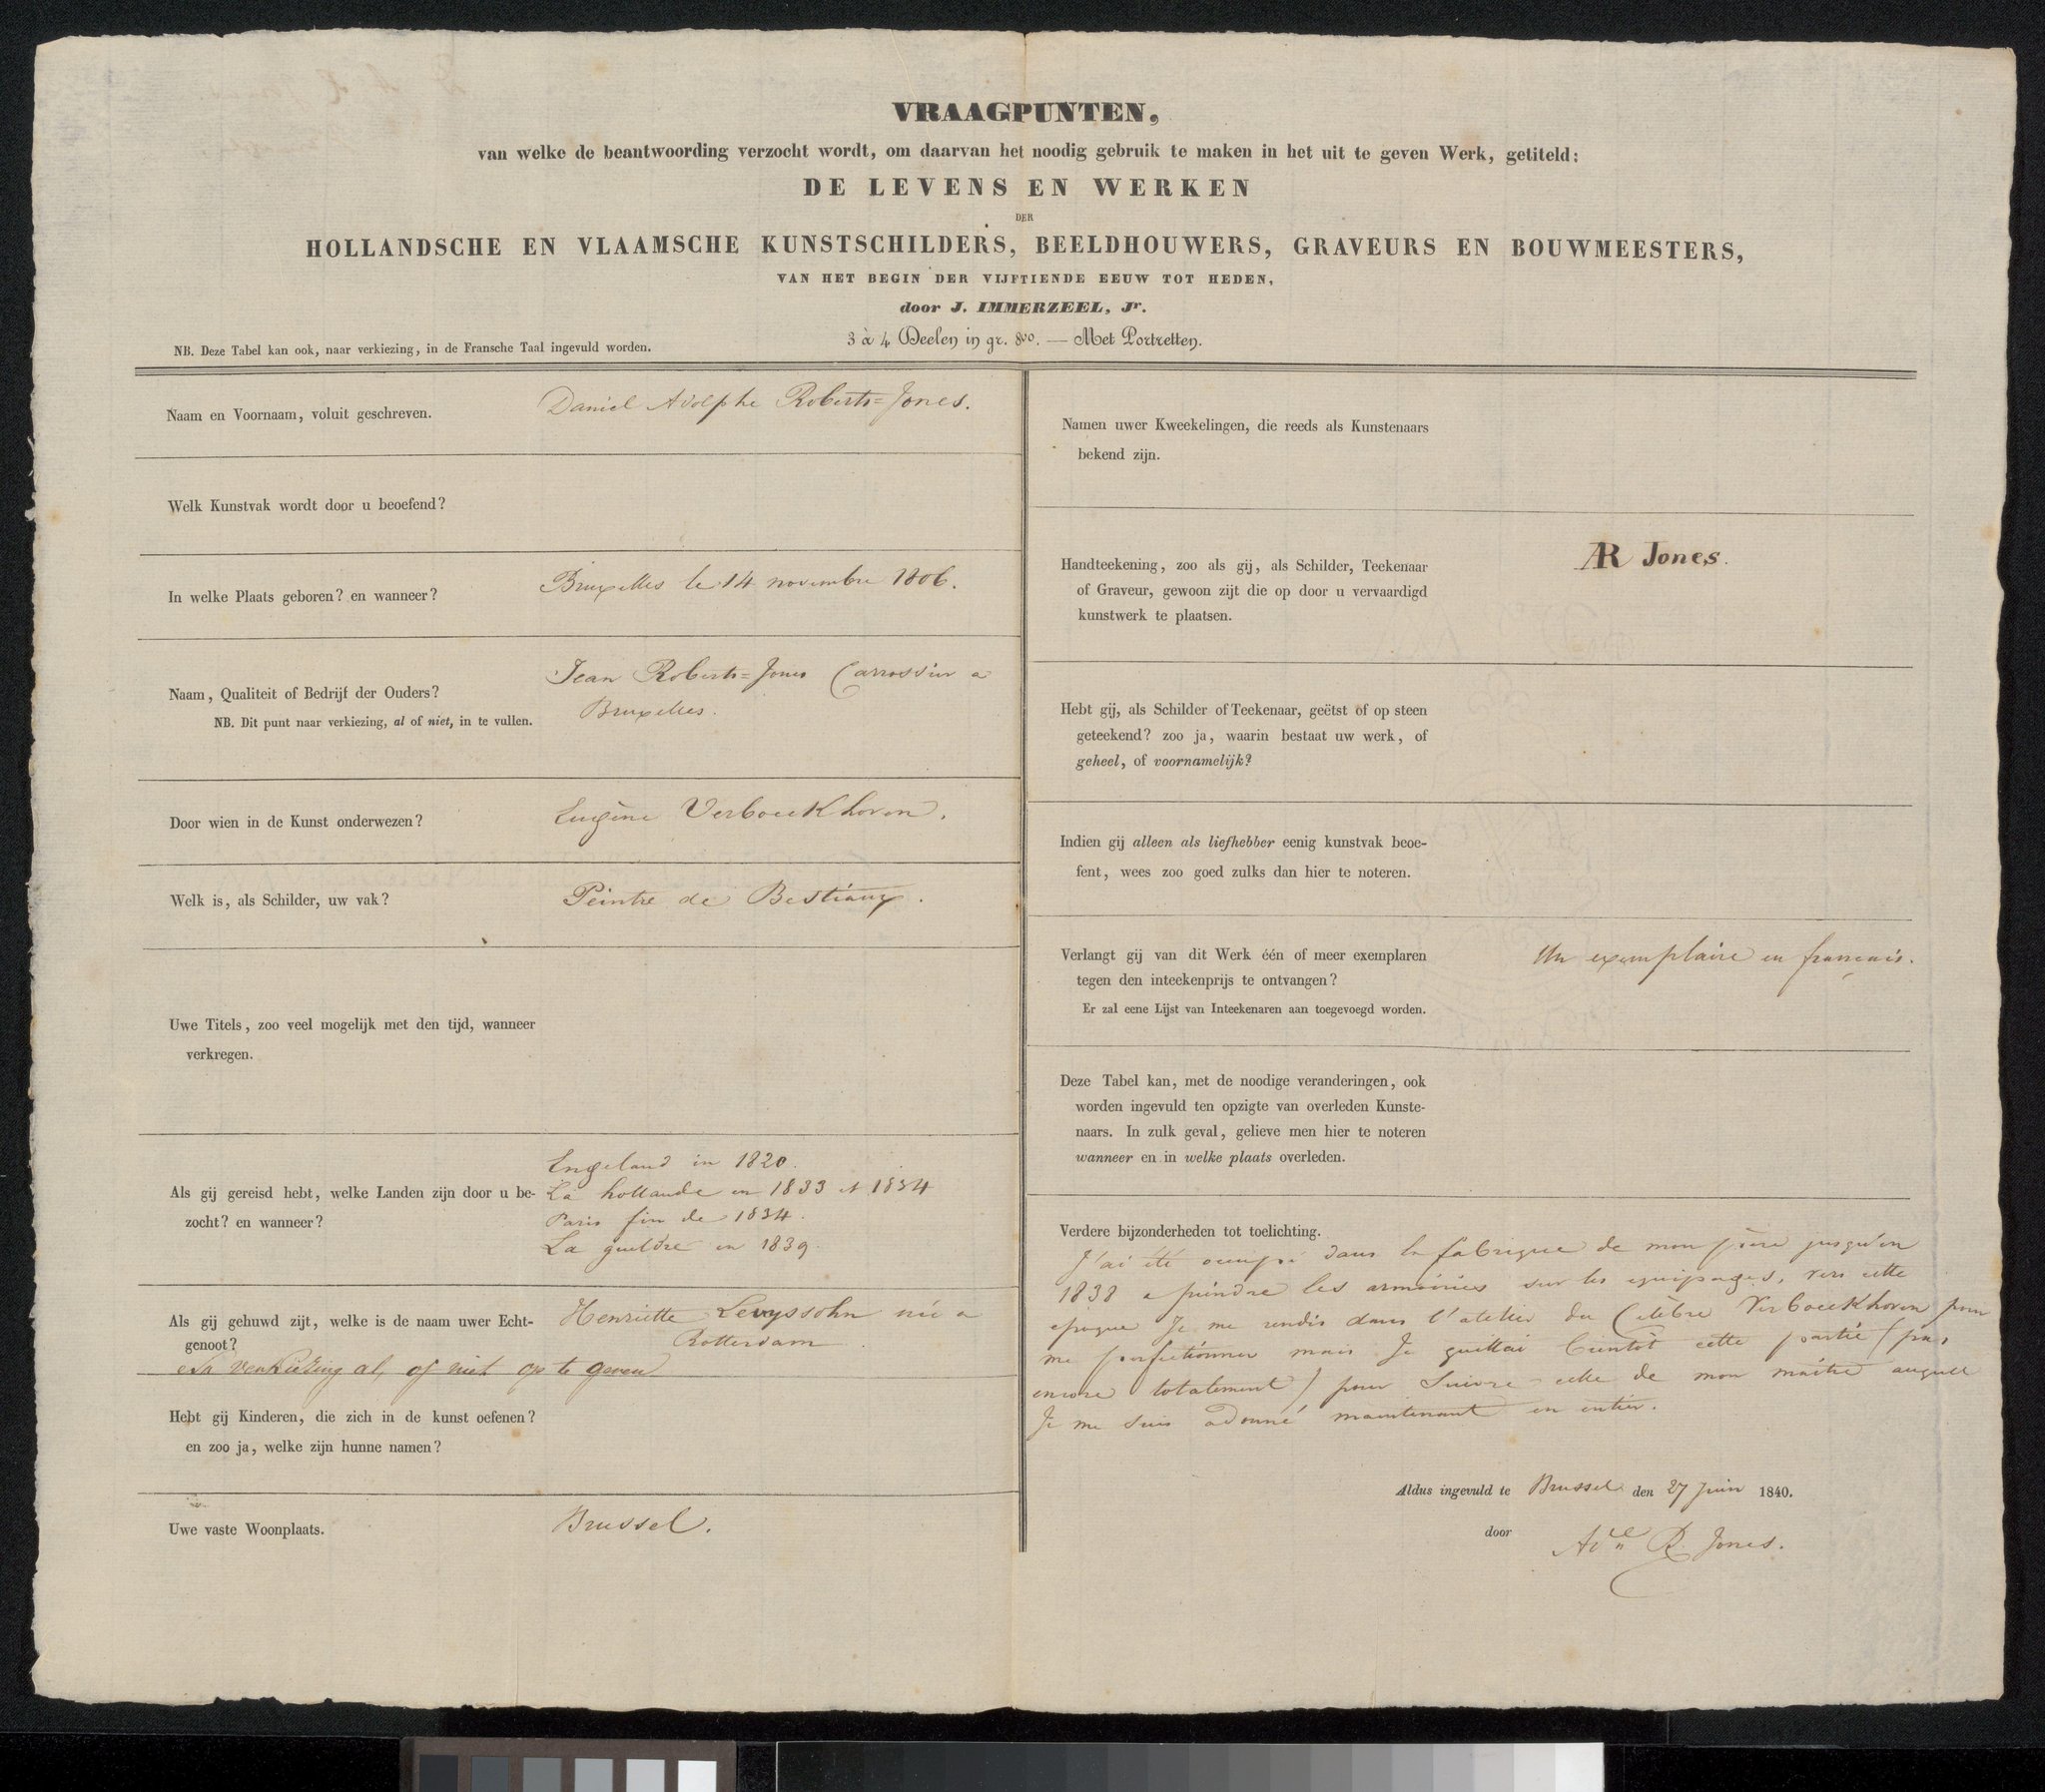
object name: questionnaire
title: Enquêteformulier ingevuld door Daniel Adolphe Robert Jones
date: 1840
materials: ink, paper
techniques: pen, printing, writing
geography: brussels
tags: brussels, painter, daniel adolphe robert jones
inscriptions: watermark, inscription: ‘Vraagpunten,/ van welke de beantwoording verzocht wordt, om daarvan het noodig gebruik te maken in het uit te geven Werk, getiteld: De levens en werken/ der Hollandsche en Vlaamsche kunstschilders, beeldhouwers,/ graveurs en bouwmeesters, van het begin der vijftiende eeuw tot heden/ door J. Immerzeel, Jr.’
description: Opgenomen in: Immerzeel, J. Jr., De levens en werken der Hollandsche en Vlaamsche kunstschilders, beeldhouwers, graveurs en bouwmeesters, van het begin der vijftiende eeuw tot heden, Amsterdam: J.C. van Kesteren, 1842-1843.